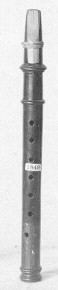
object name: chalumeau in f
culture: british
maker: francis w. galpin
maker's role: maker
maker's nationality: british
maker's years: 1858-1945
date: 1801-1900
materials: wood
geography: france or england